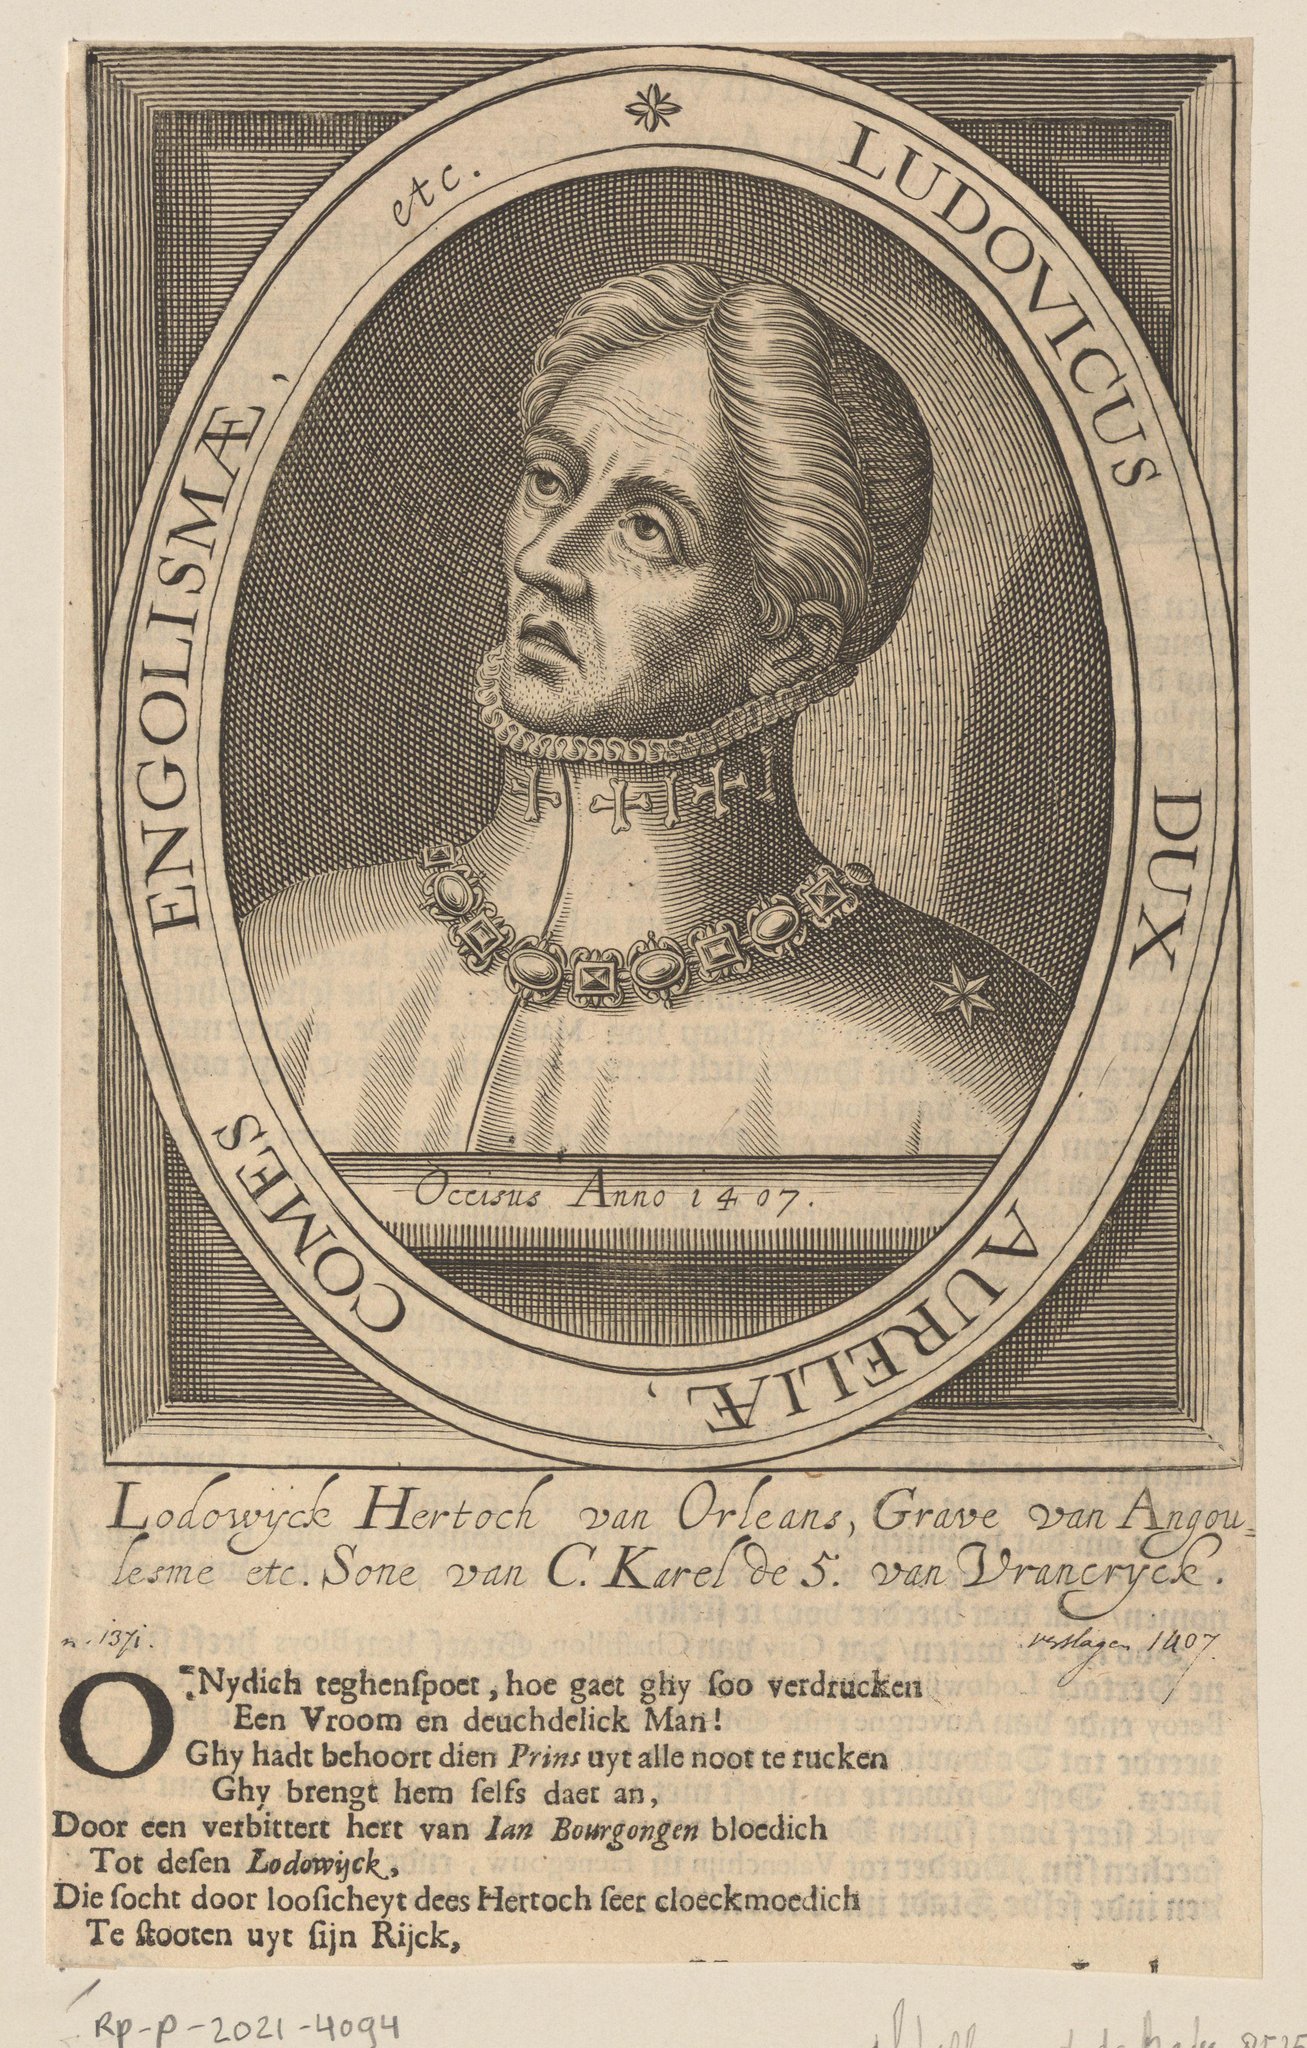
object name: book illustration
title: Portret van Lodewijk I van Orléans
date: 1617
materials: paper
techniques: engraving, letterpress printing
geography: delft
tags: paris, earl, ornament ~ medallion, historical persons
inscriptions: inscription: ‘n. 1371/ verslagen 1407’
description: Prent uit: Tooneel der beroemder hertogen princen graven ende krygs-helden van christenrijck binnen deze drij laetste eeuwen. Delft: Nicolaes de Clerck, 1617, p. 519. De prent is mogelijk ook gebruikt in edities van Van Meterens 'Nederlandsche historien'.